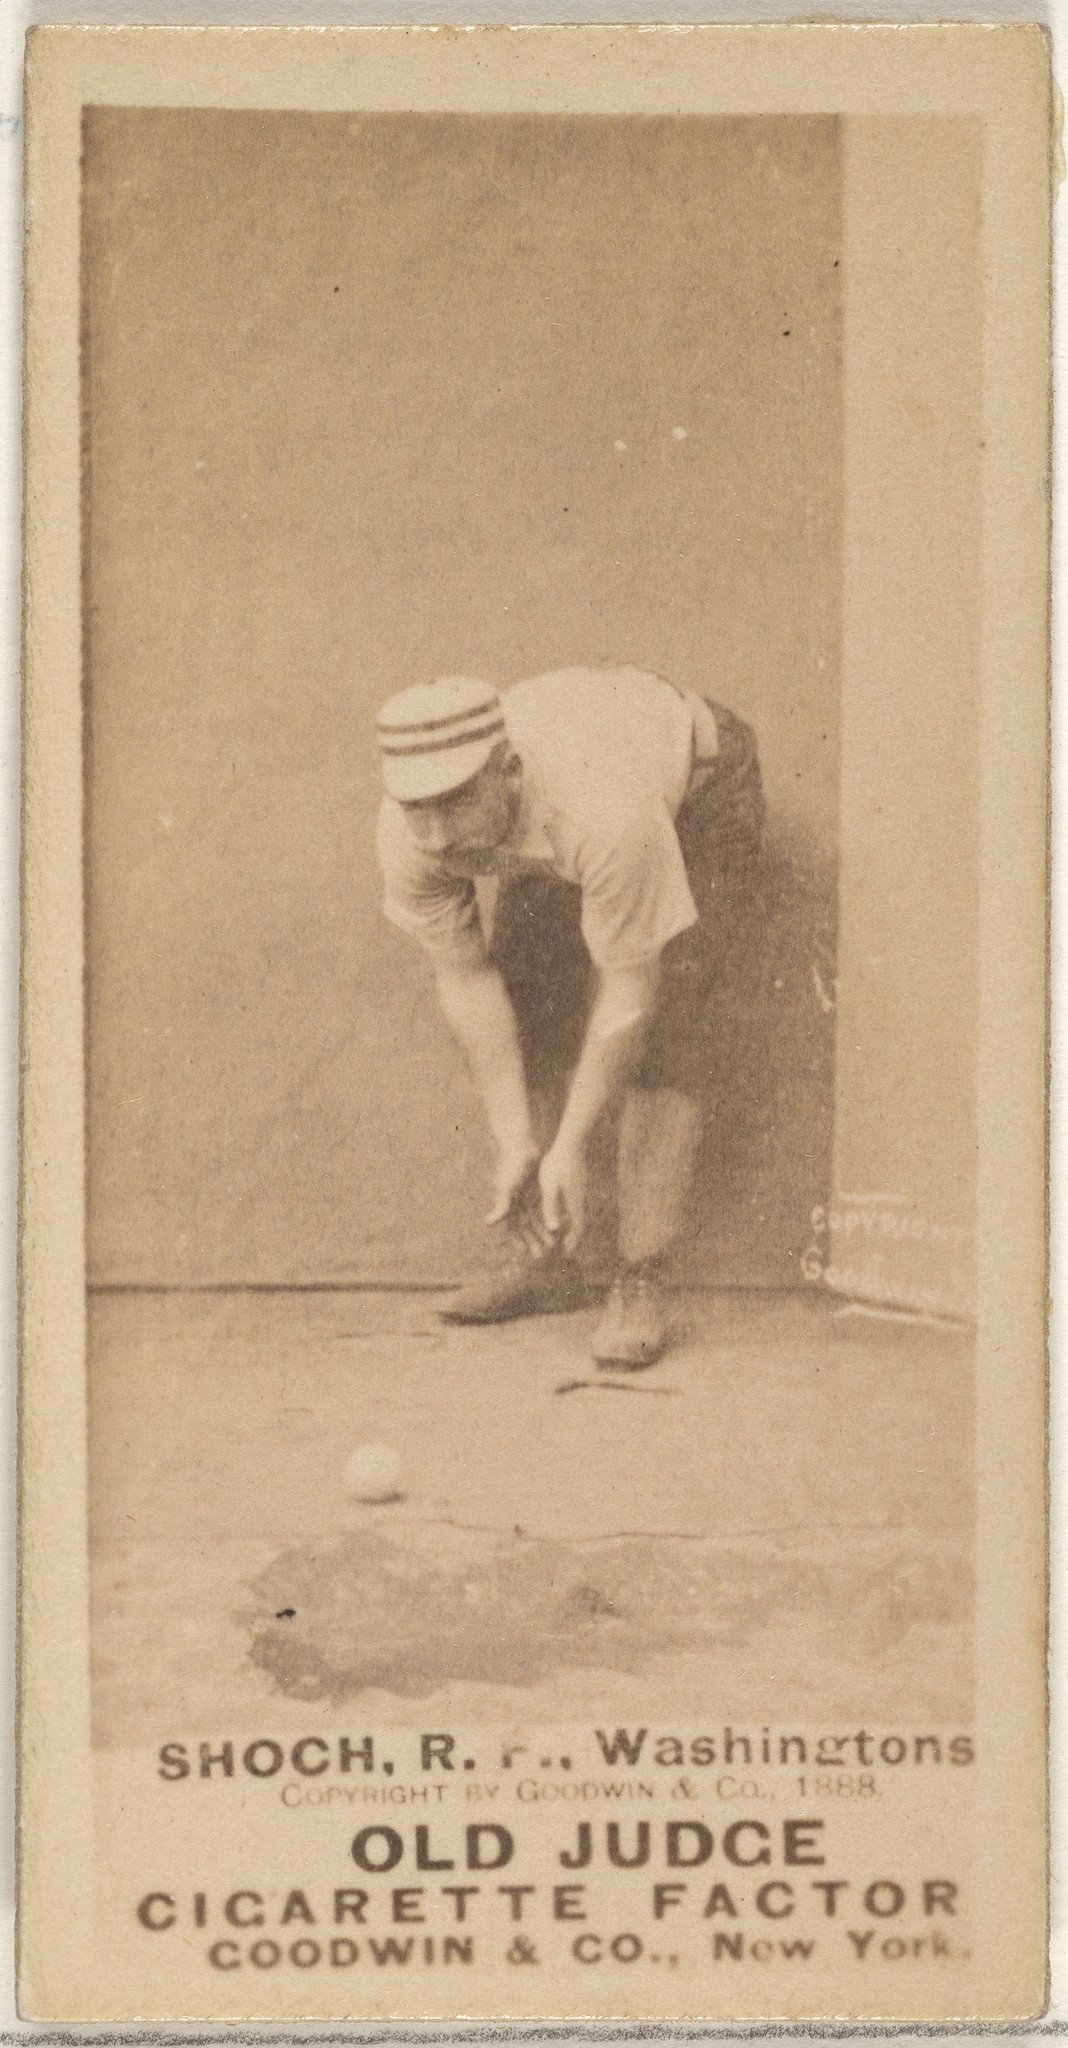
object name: baseball card, photograph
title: George Quintus Shoch, Right Field, Washington Nationals, from the Old Judge series (N172) for Old Judge Cigarettes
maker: goodwin & company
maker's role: publisher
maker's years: 1850-1950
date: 1888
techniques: albumen silver print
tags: men,portraits,baseball,athletes